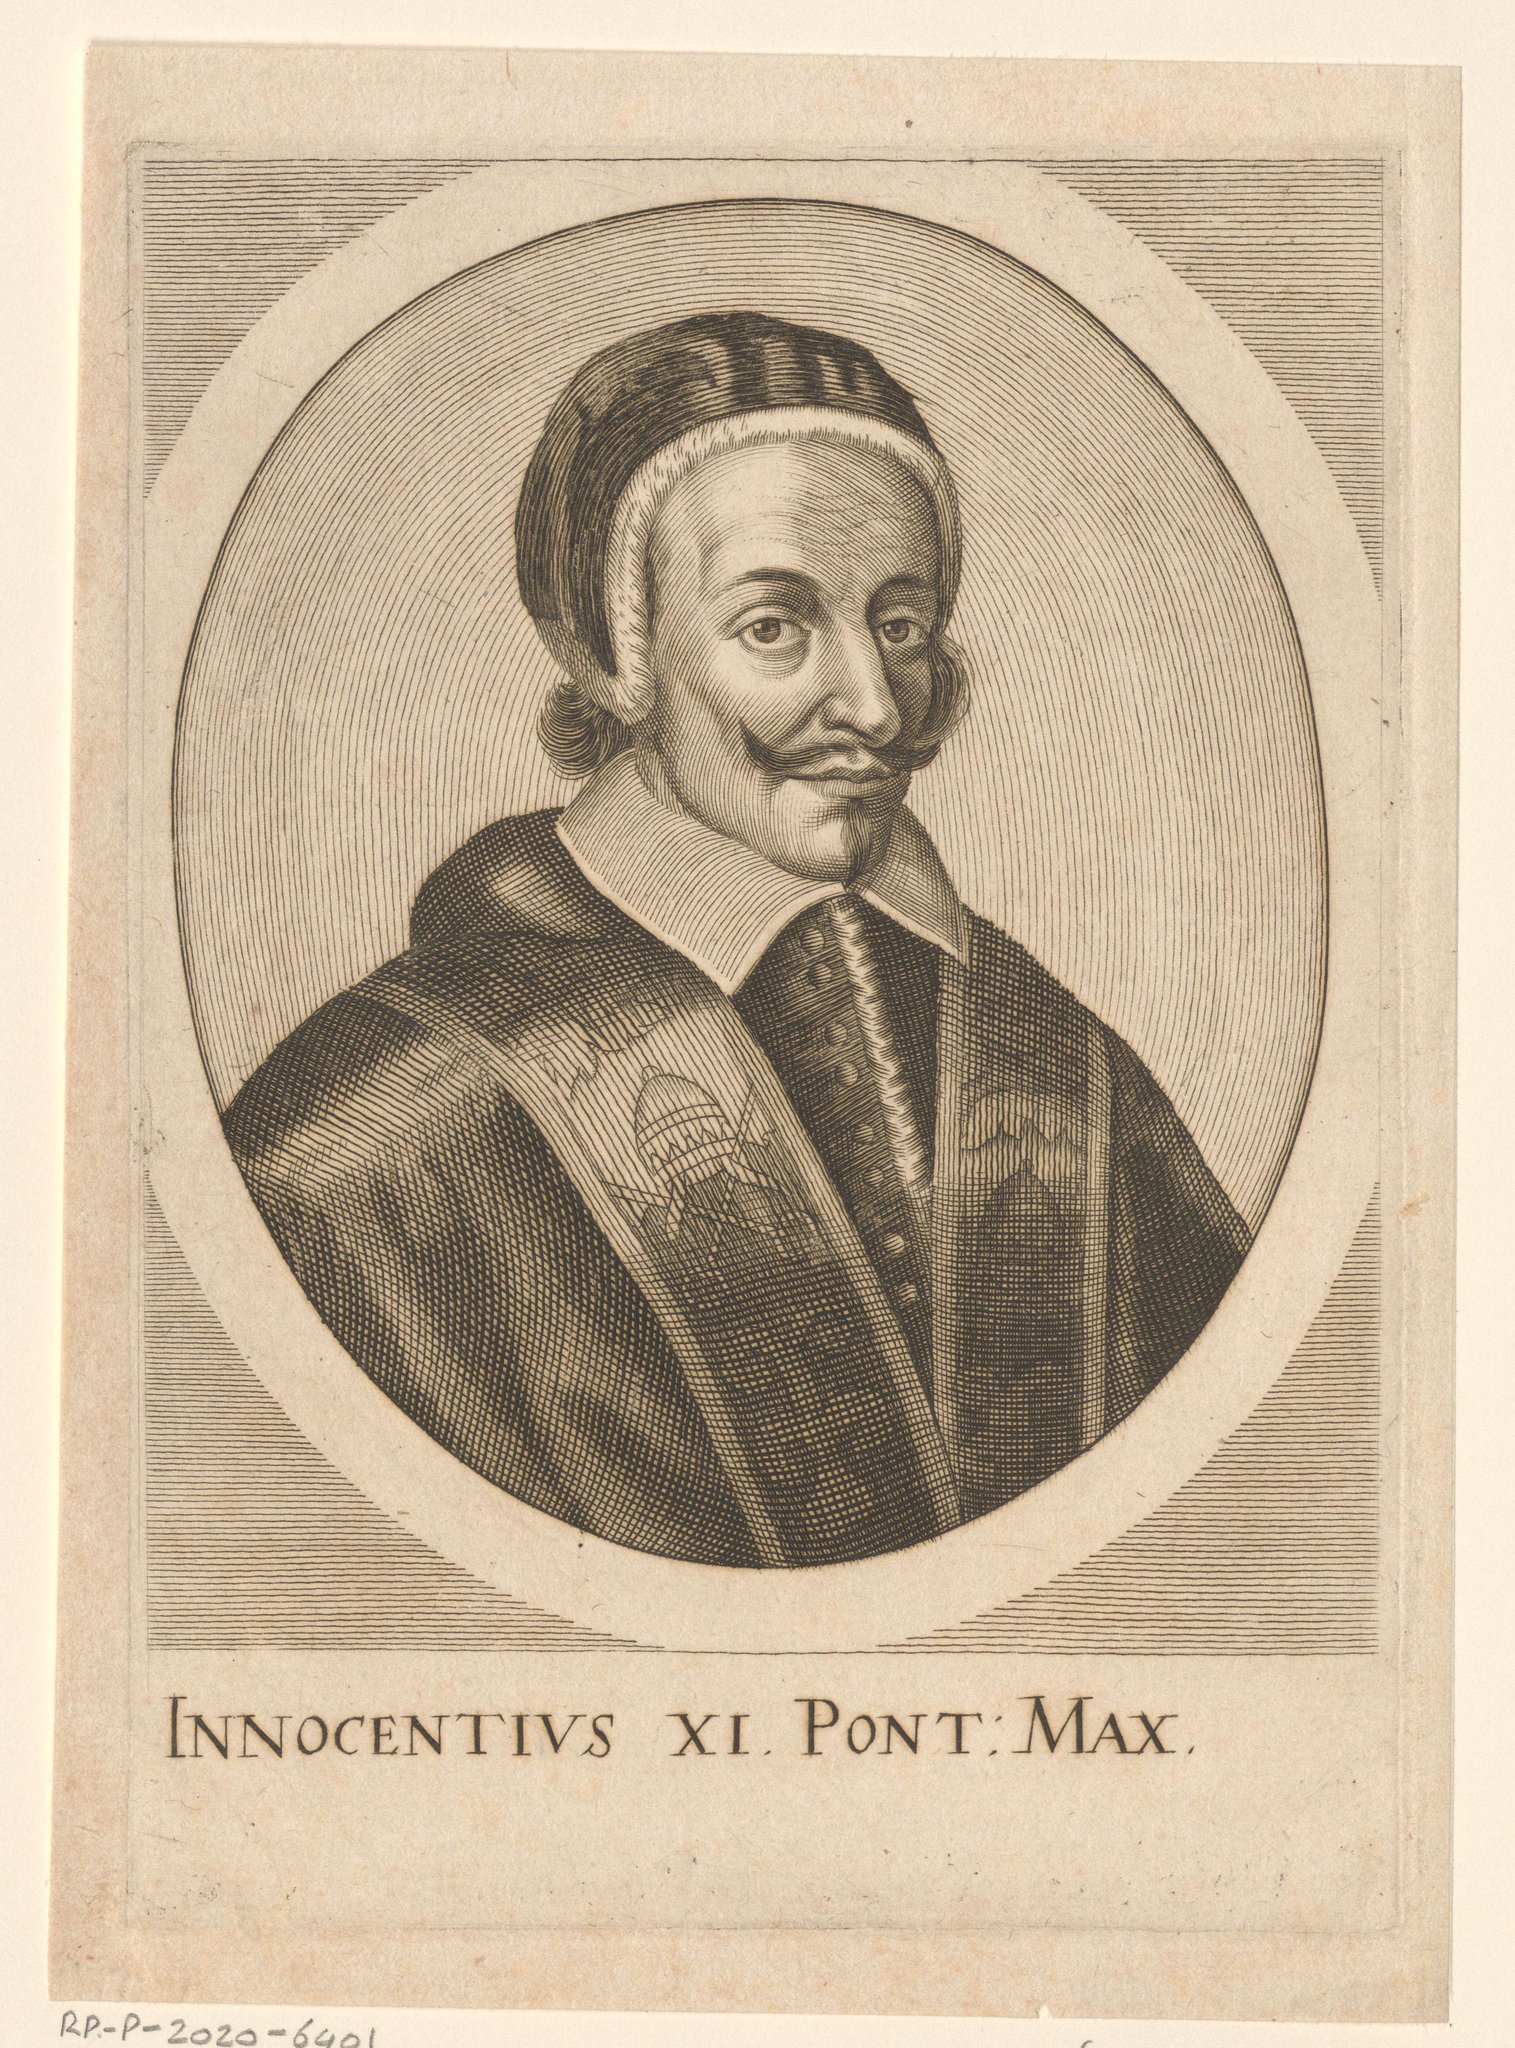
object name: print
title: Portret van paus Innocentius XI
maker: Anonymous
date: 1682-1698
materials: paper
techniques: engraving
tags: rome, clergyman, innocentius xi, historical persons, pope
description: Prent mogelijk uit: Theatrum Europaeum (...). Frankfurt: erven Matthaus Merian, 1691, dl. 12. Of uit eerdere en latere publicaties (1682 en 1698).